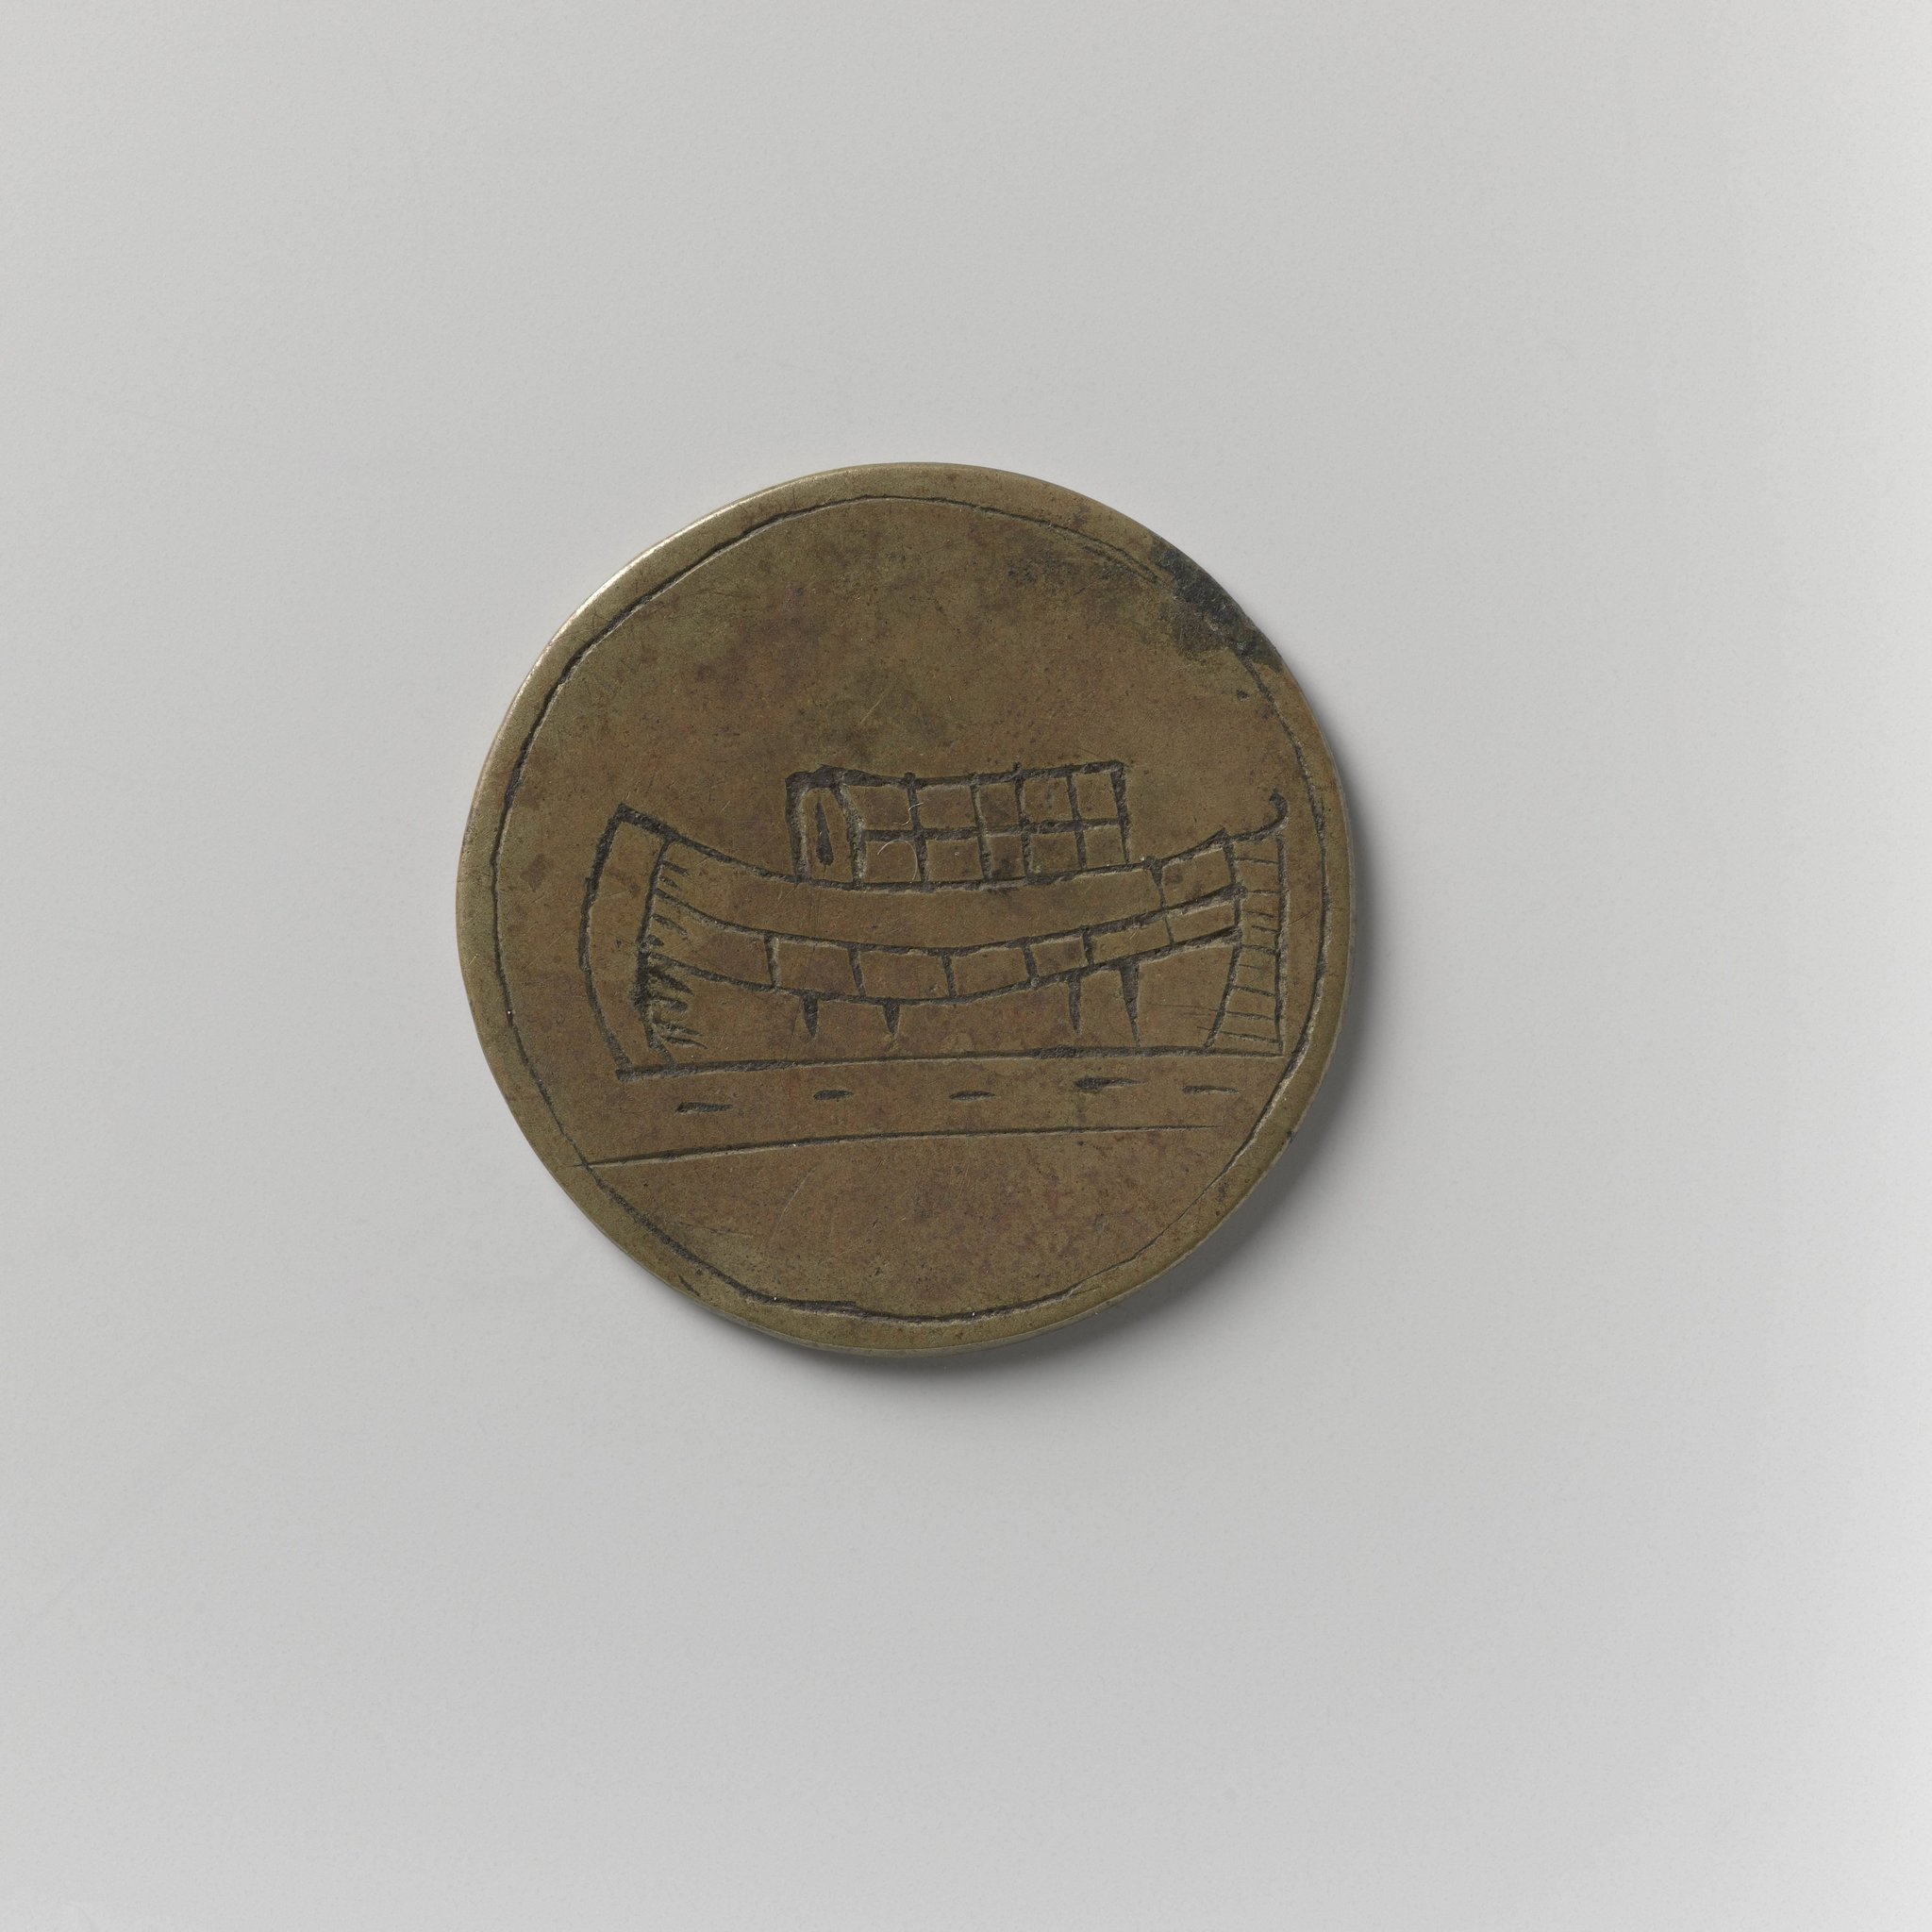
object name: medal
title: Korenlichtermansgilde van Amsterdam, gildepenning van Jacob Jacobsen de Deen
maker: Anonymous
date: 1695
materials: brass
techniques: engraving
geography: amsterdam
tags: amsterdam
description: Messing penning. Voorzijde: korenlichter. Keerzijde: opschrift